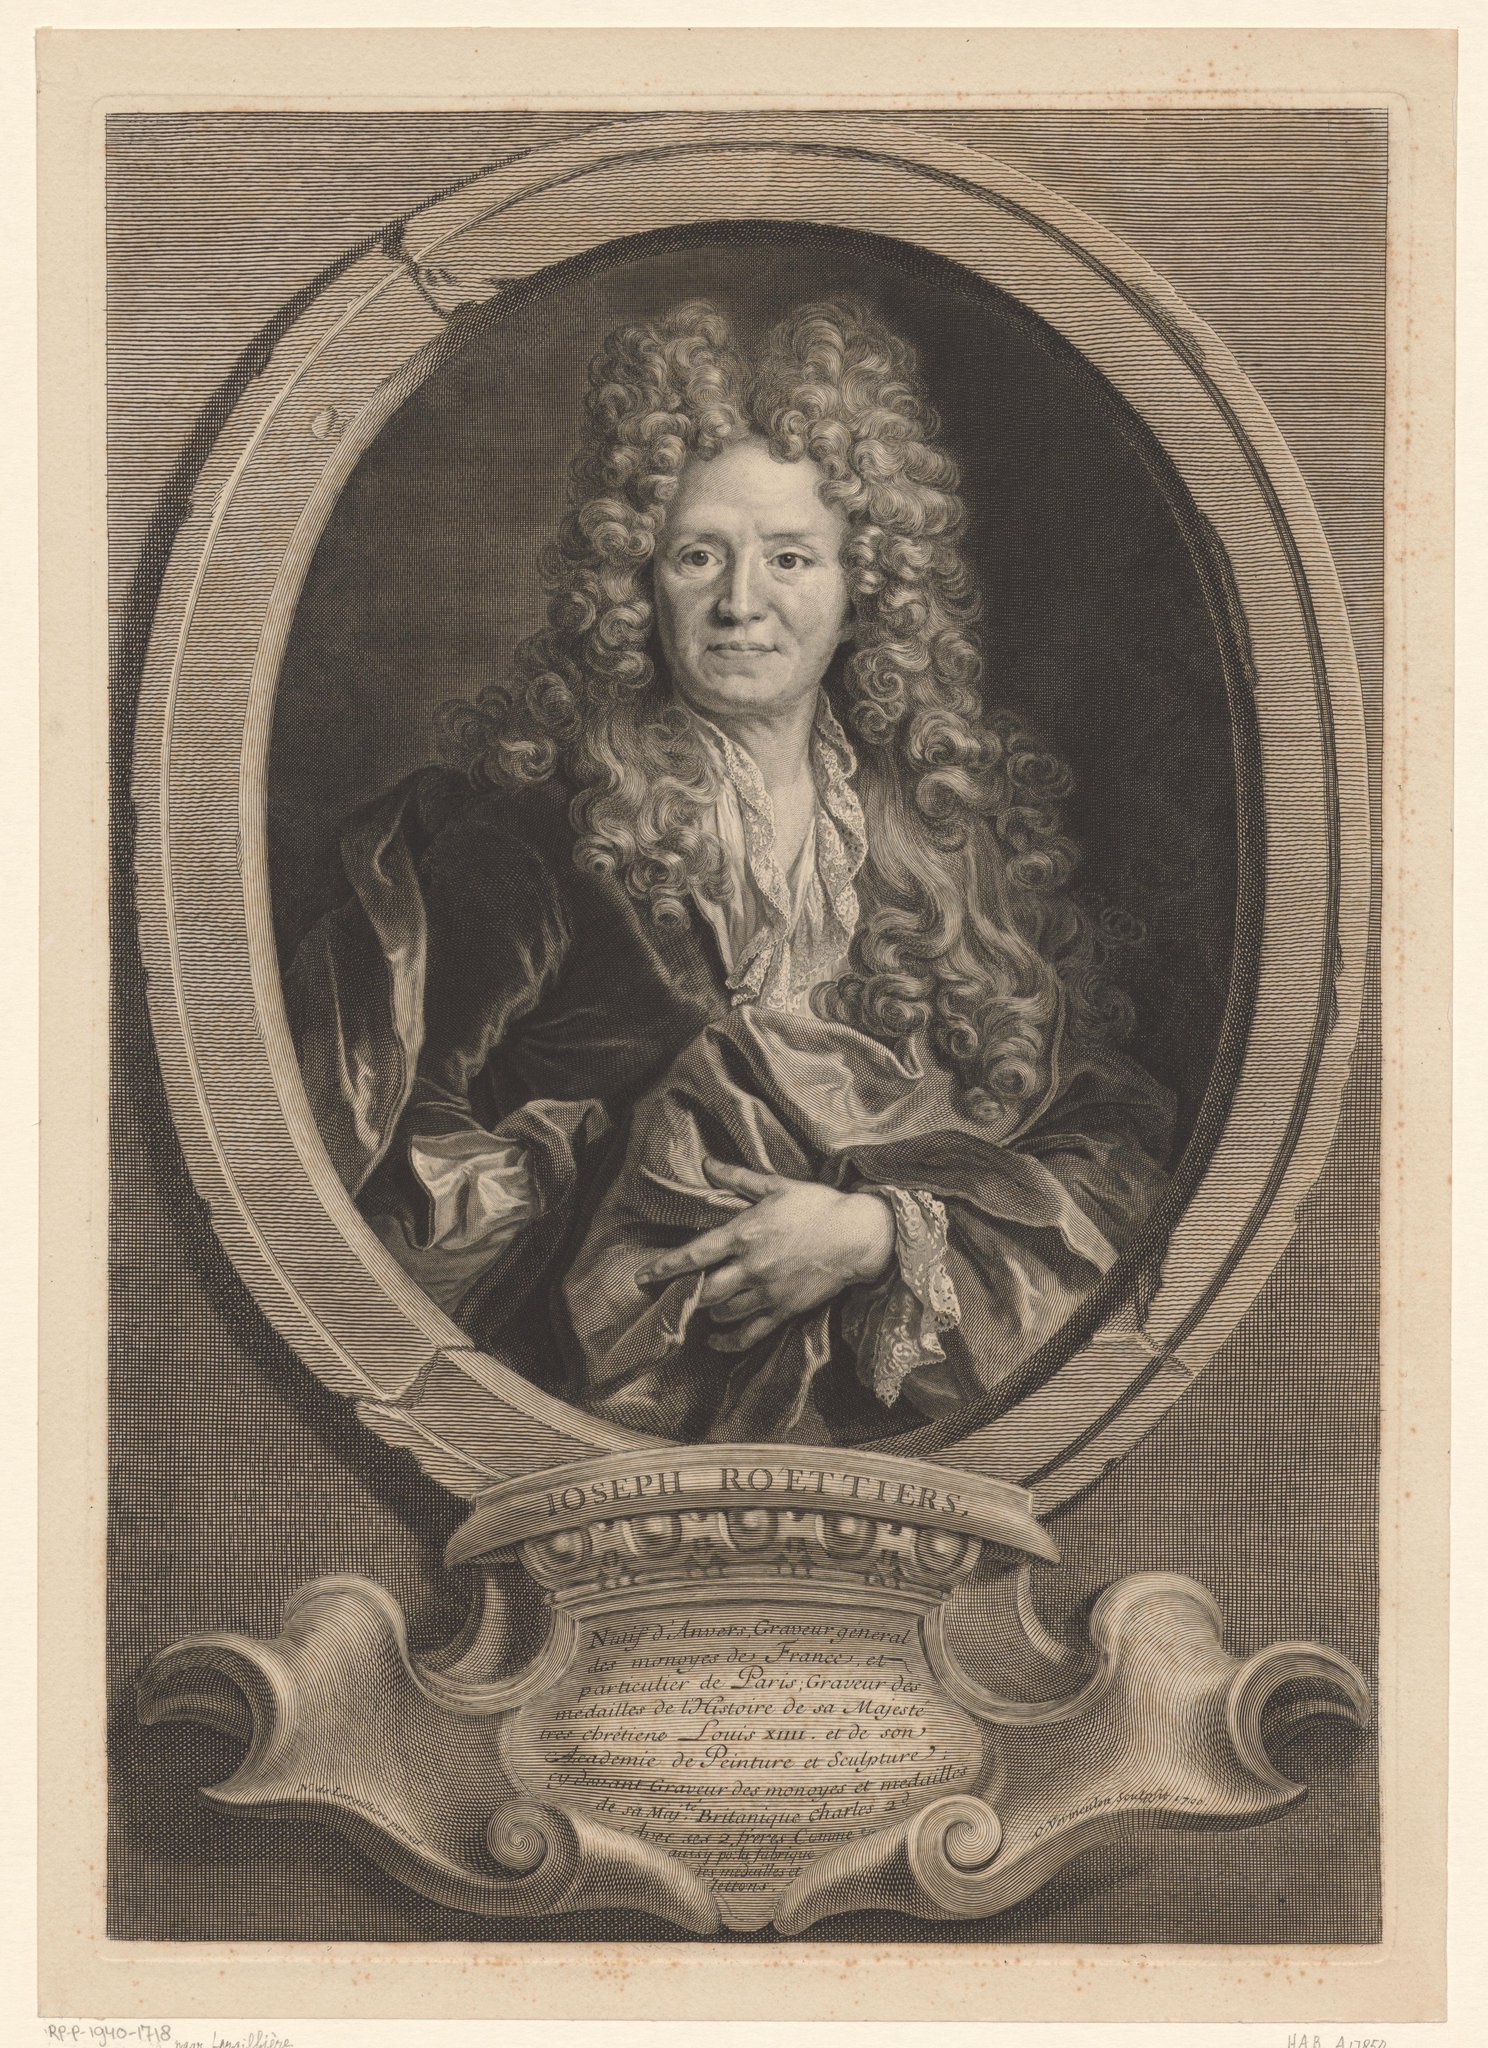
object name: print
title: Portret van Joseph Roettiers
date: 1700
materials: paper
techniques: engraving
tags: antwerp, goldsmith, joseph roettiers, historical persons, portrait, self-portrait of painter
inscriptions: collector's mark: Lugt 2166, collector's mark: Lugt 2760